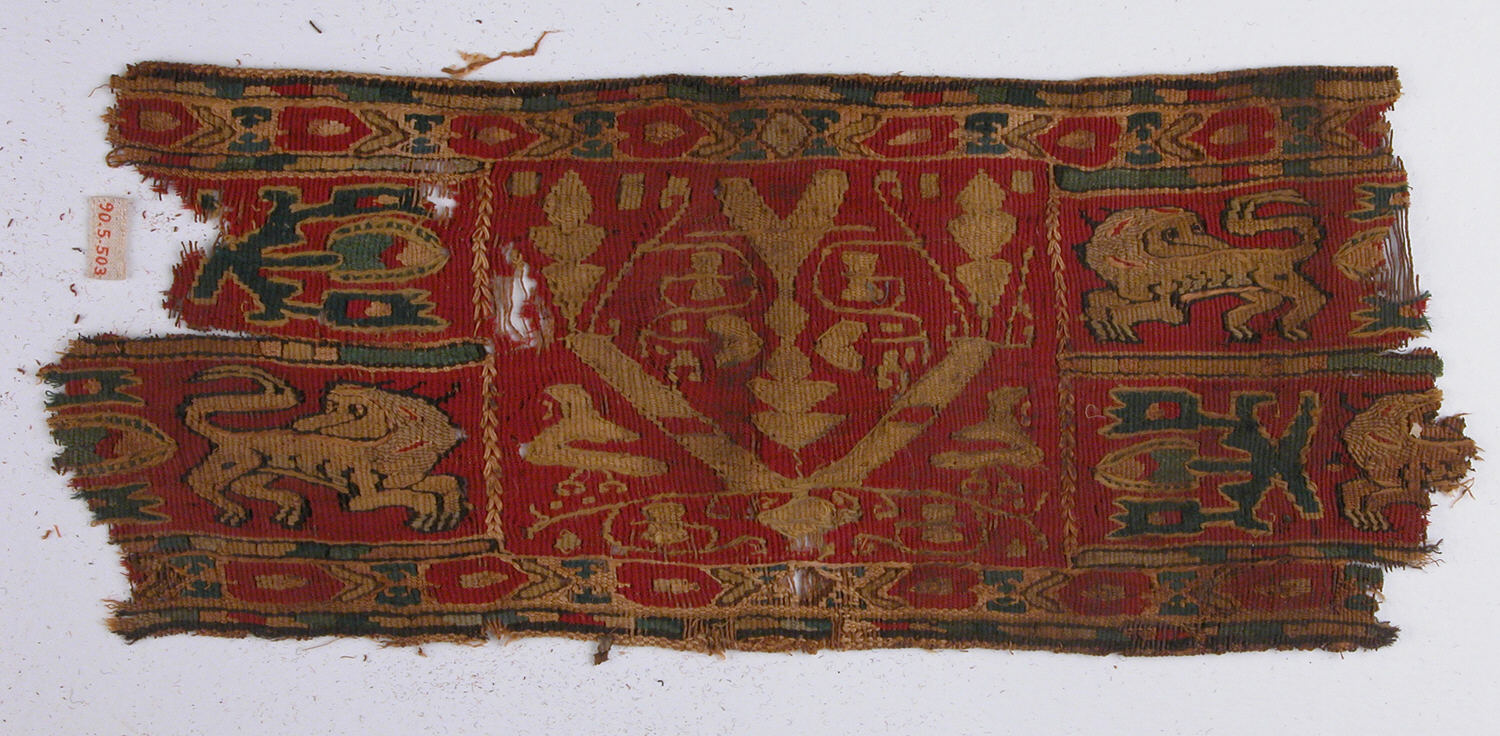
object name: textile fragment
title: Fragment of a Sleeve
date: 501-700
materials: linen, wool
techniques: weave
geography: egypt